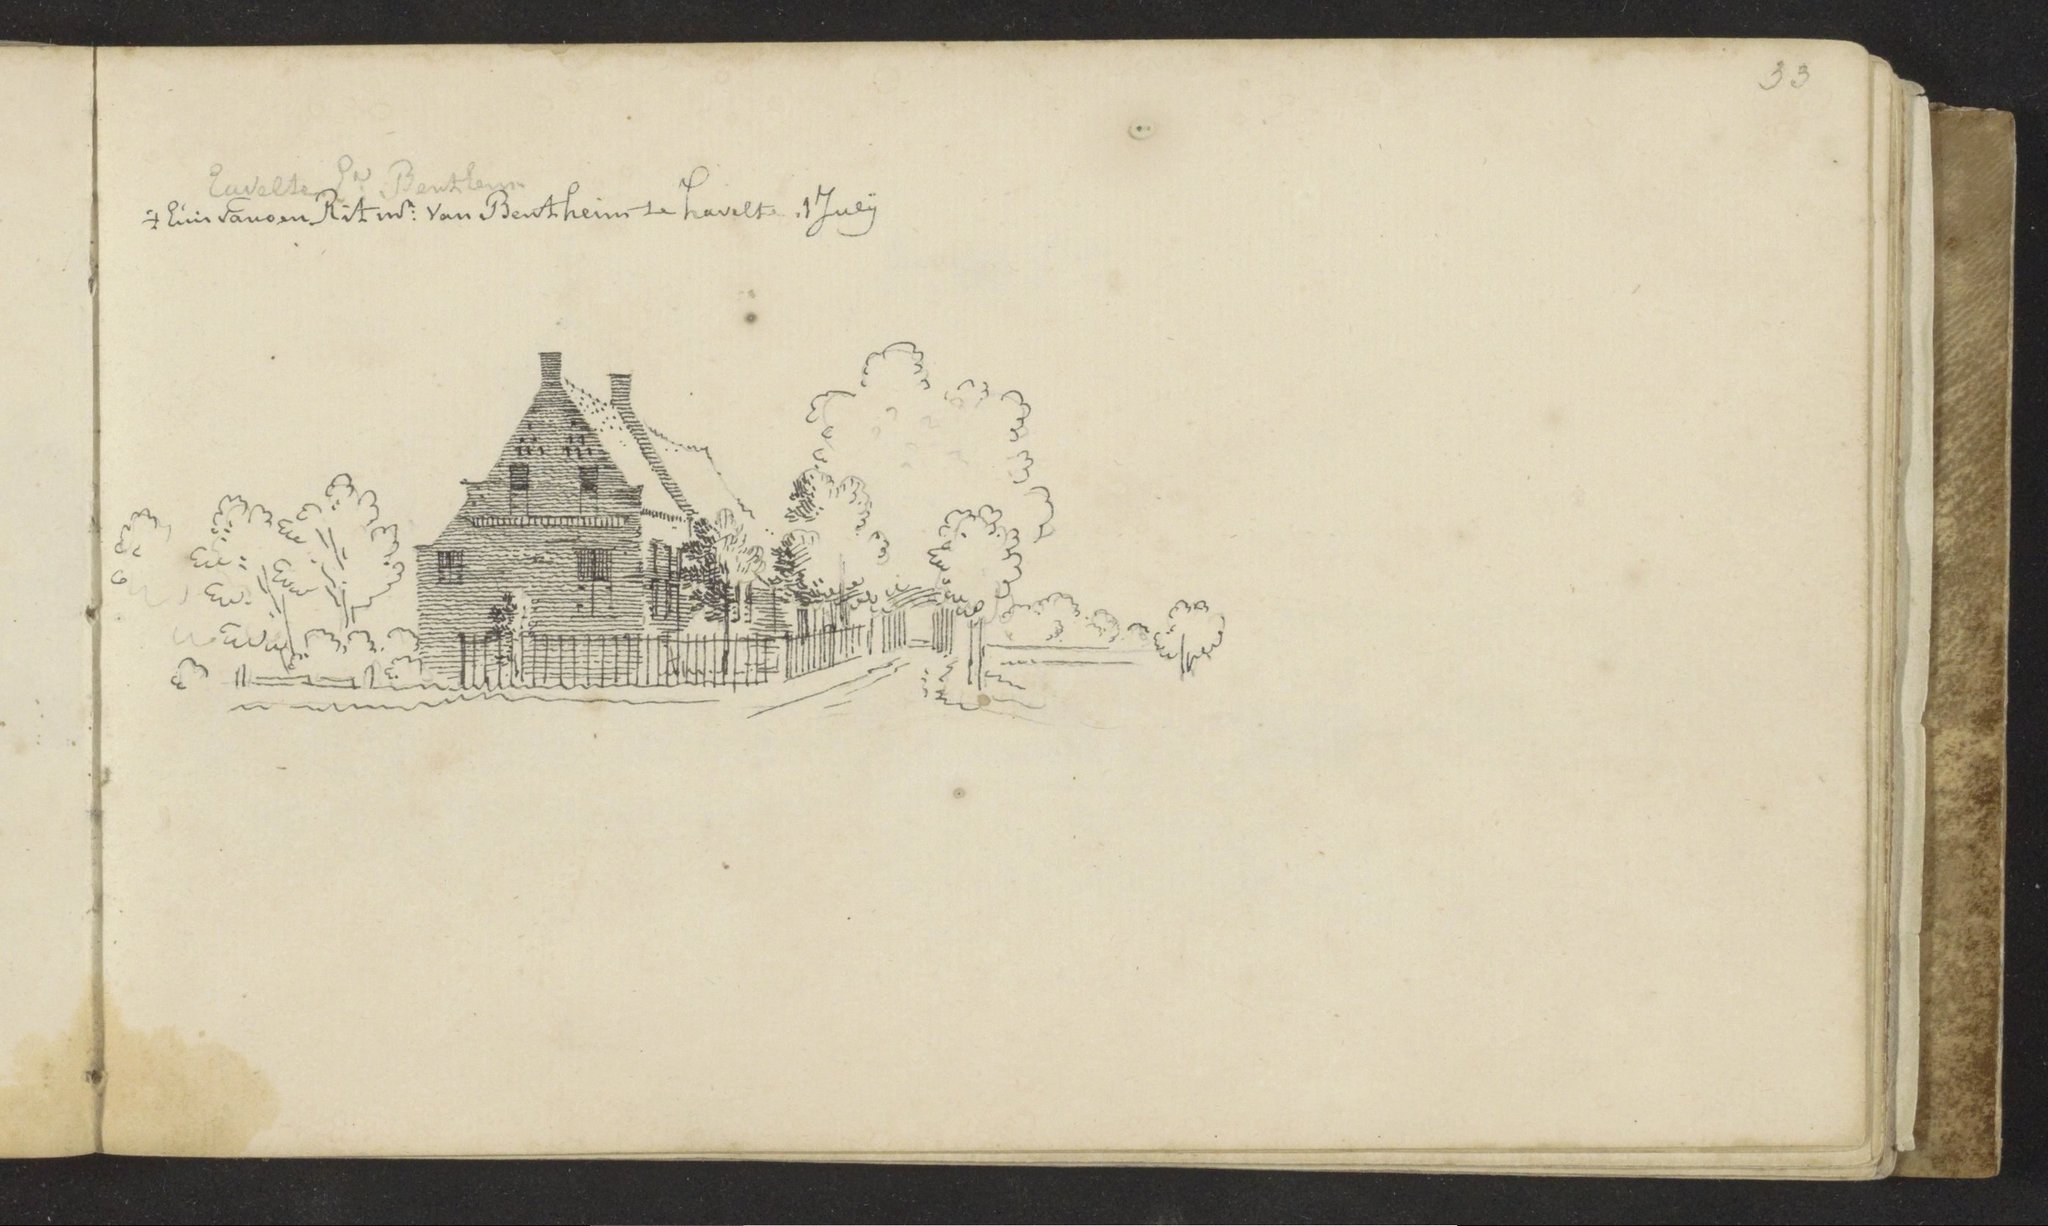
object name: sketchbook leaf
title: Huis van ritmeester van Benthem te Havelte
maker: abraham de haen (ii)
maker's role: draughtsman, print maker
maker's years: 1707-1748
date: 1732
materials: ink, paper, pencil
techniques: pen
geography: havelte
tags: farm or solitary house in landscape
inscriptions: date and inscription: ‘'t huis vanden Ritmr: van Bentheim te Havelte.1Julij’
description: Blad 33 recto uit een schetsboek met 51 bladen.